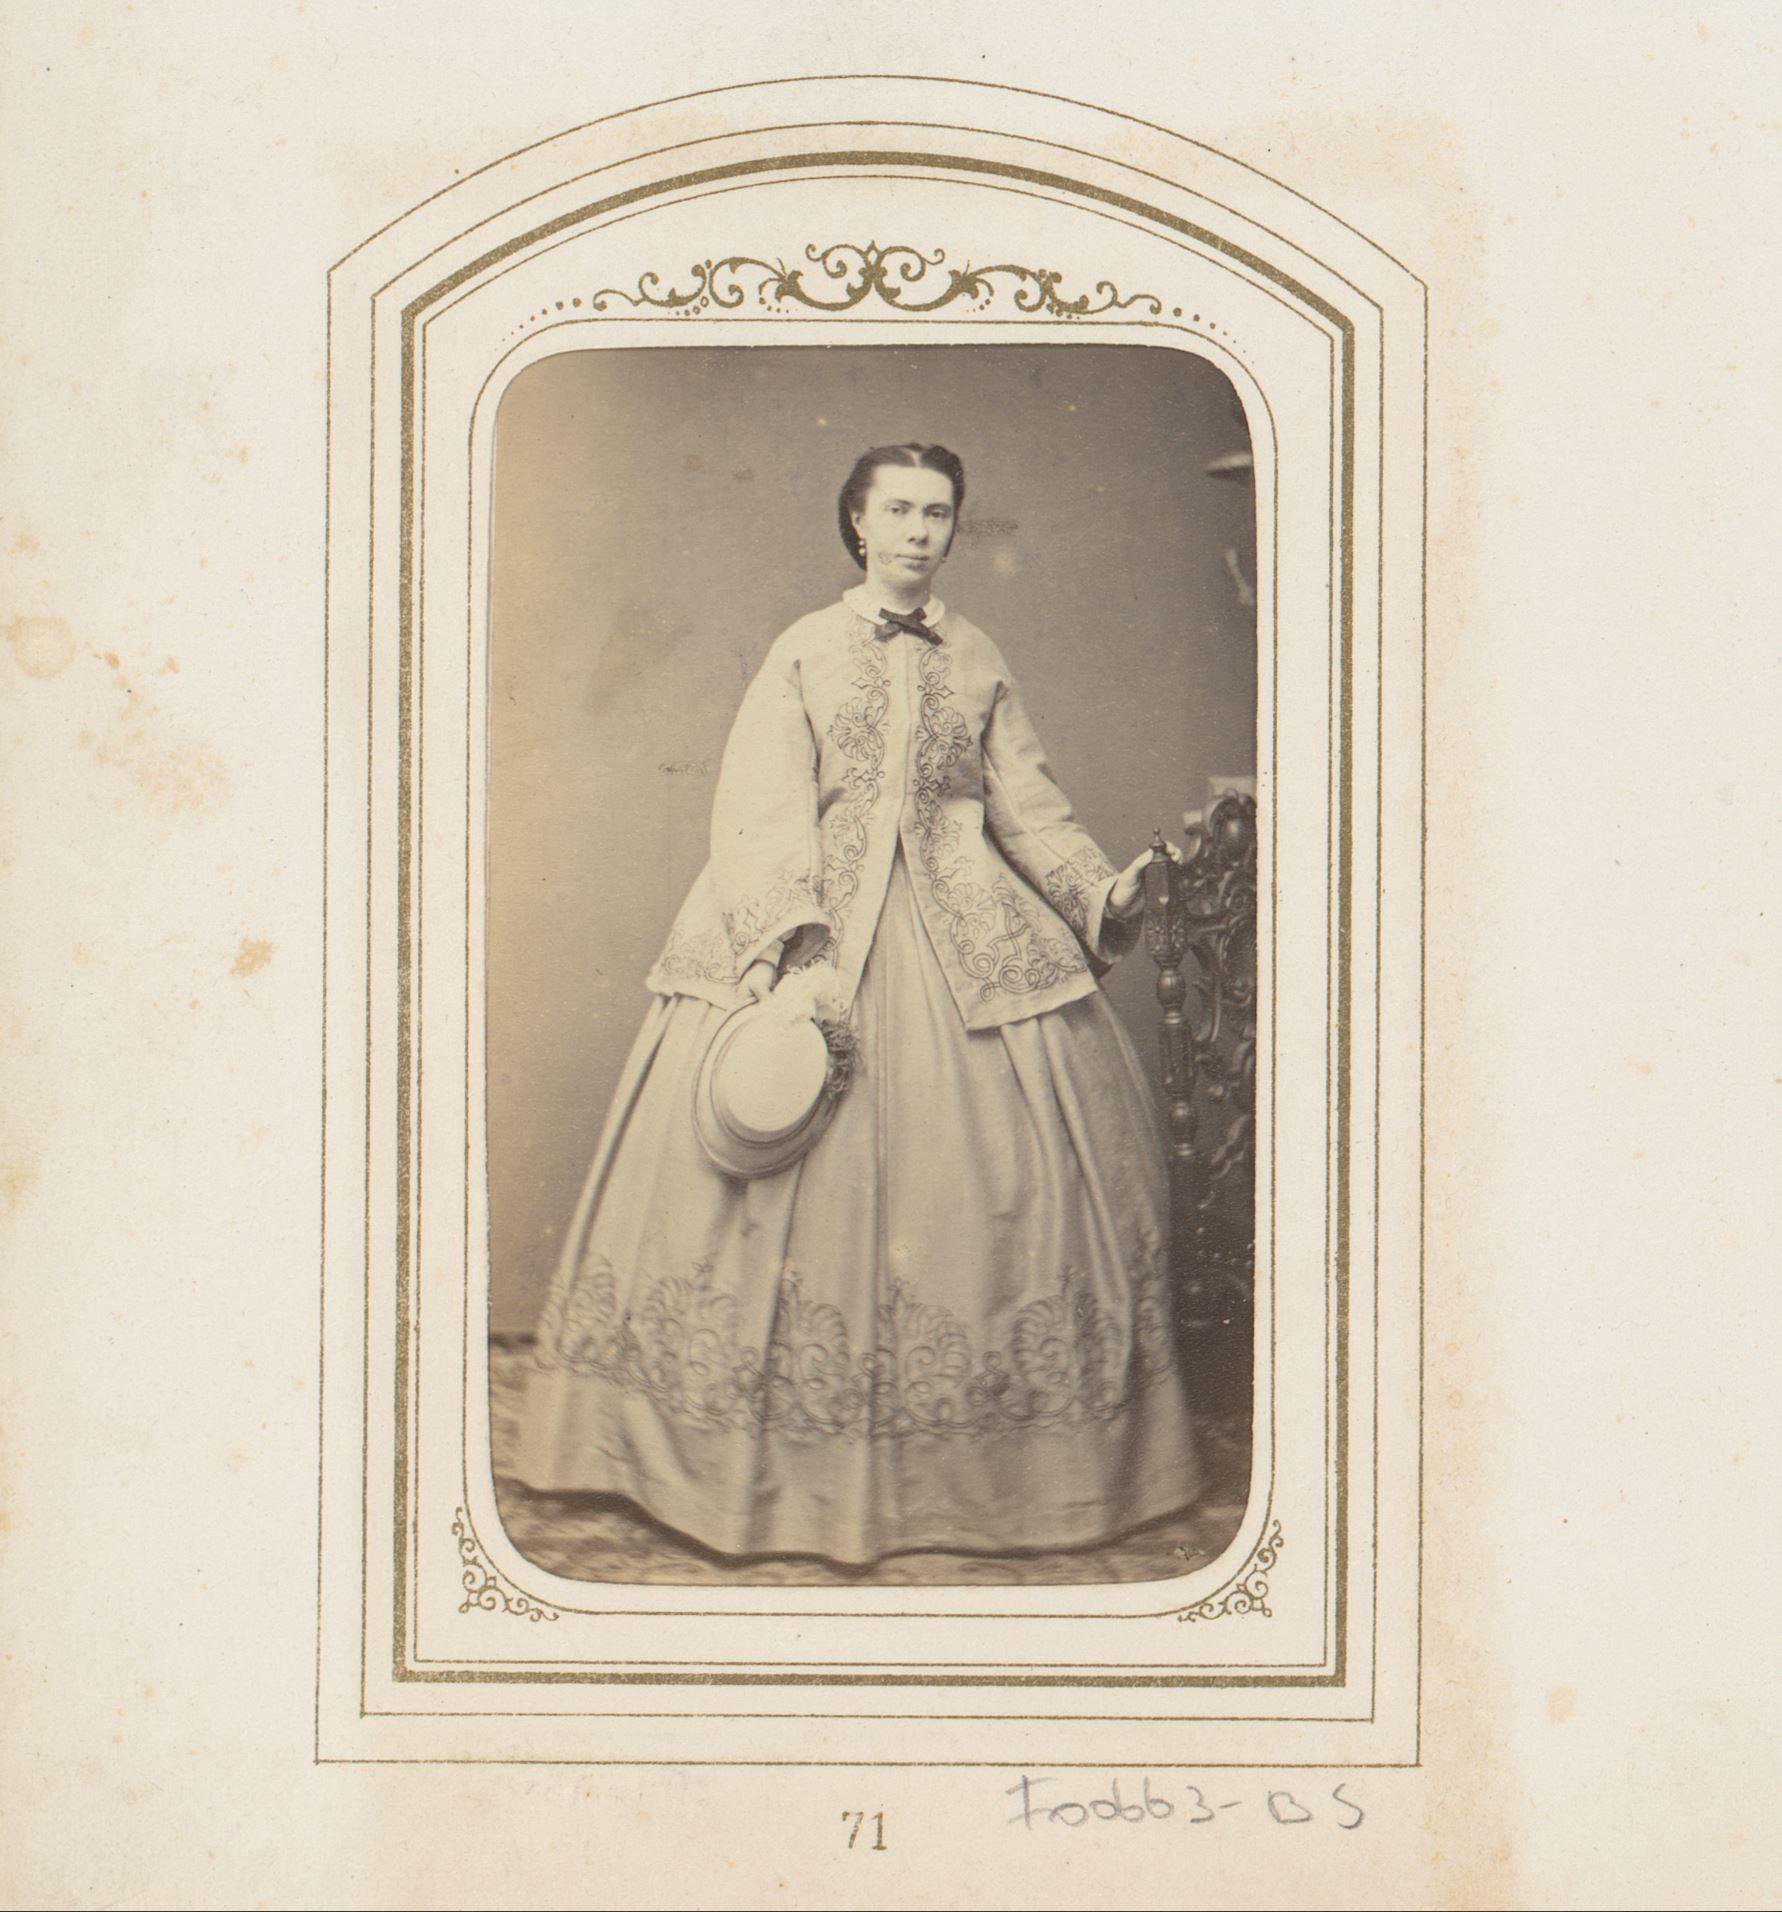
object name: carte de visite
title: Portret van een staande vrouw met hoed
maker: lambertus martinus delboy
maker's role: fotograaf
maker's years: 1840-1891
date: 1860-1870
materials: cardboard, photographic support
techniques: albumen print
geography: the hague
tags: historical persons - bb - woman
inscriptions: inscription: ‘Photographie van L.M. Delboy te 's Hage’, number: ‘71’